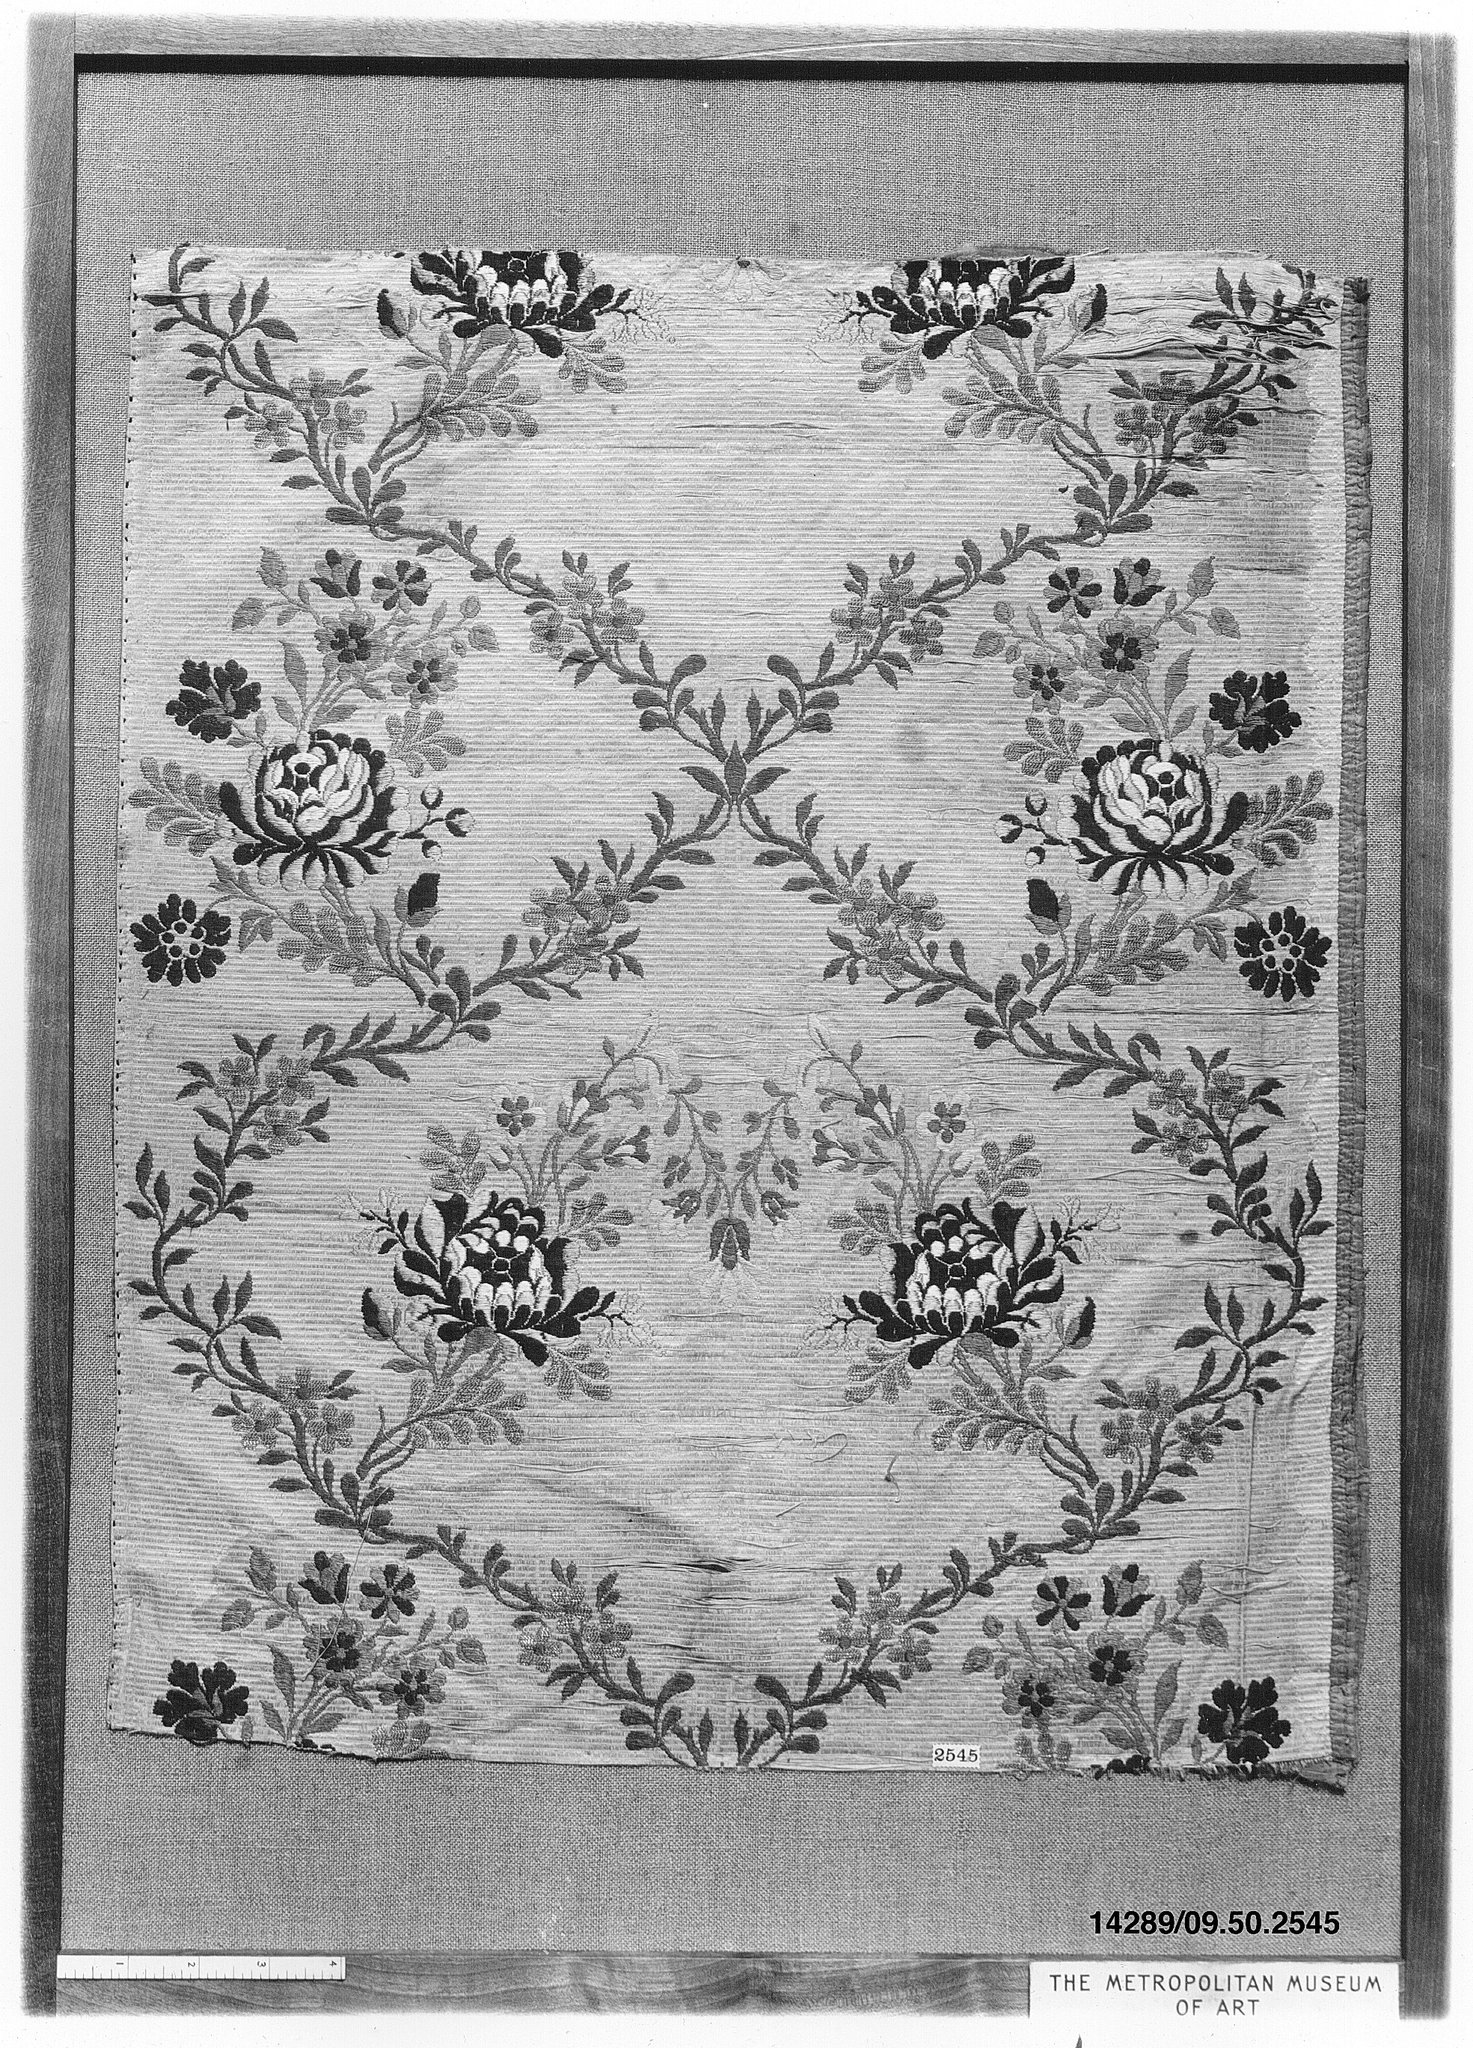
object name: piece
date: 1760-1770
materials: metal thread, silk, wool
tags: flowers,leaves